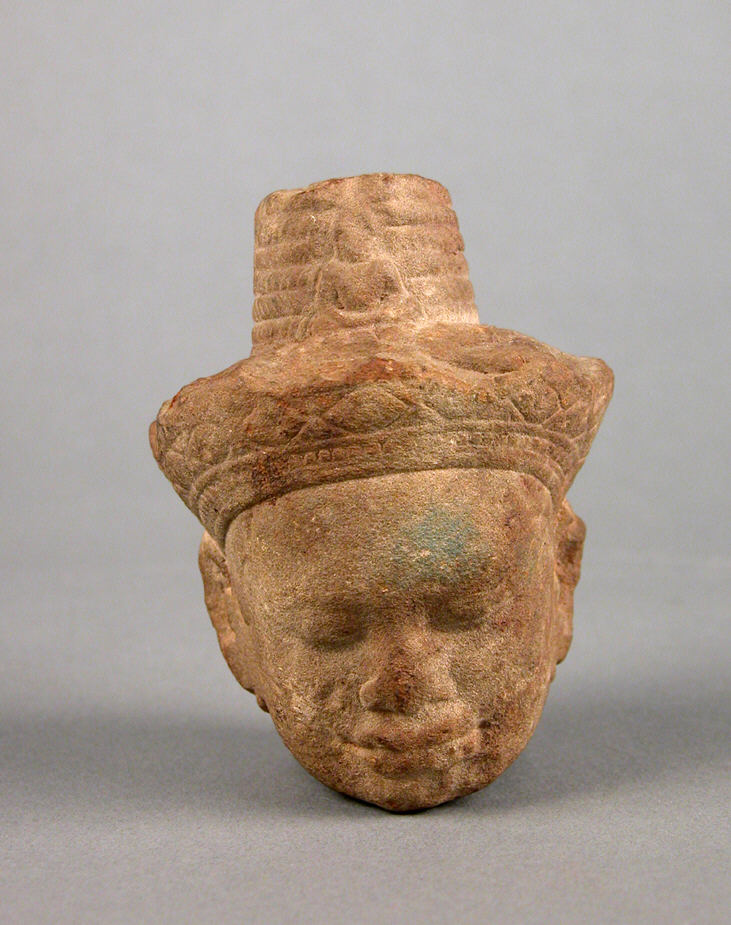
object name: head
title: Head of Lokeshvara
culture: cambodian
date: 1151-1200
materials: stone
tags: heads,buddhism,bodhisattvas